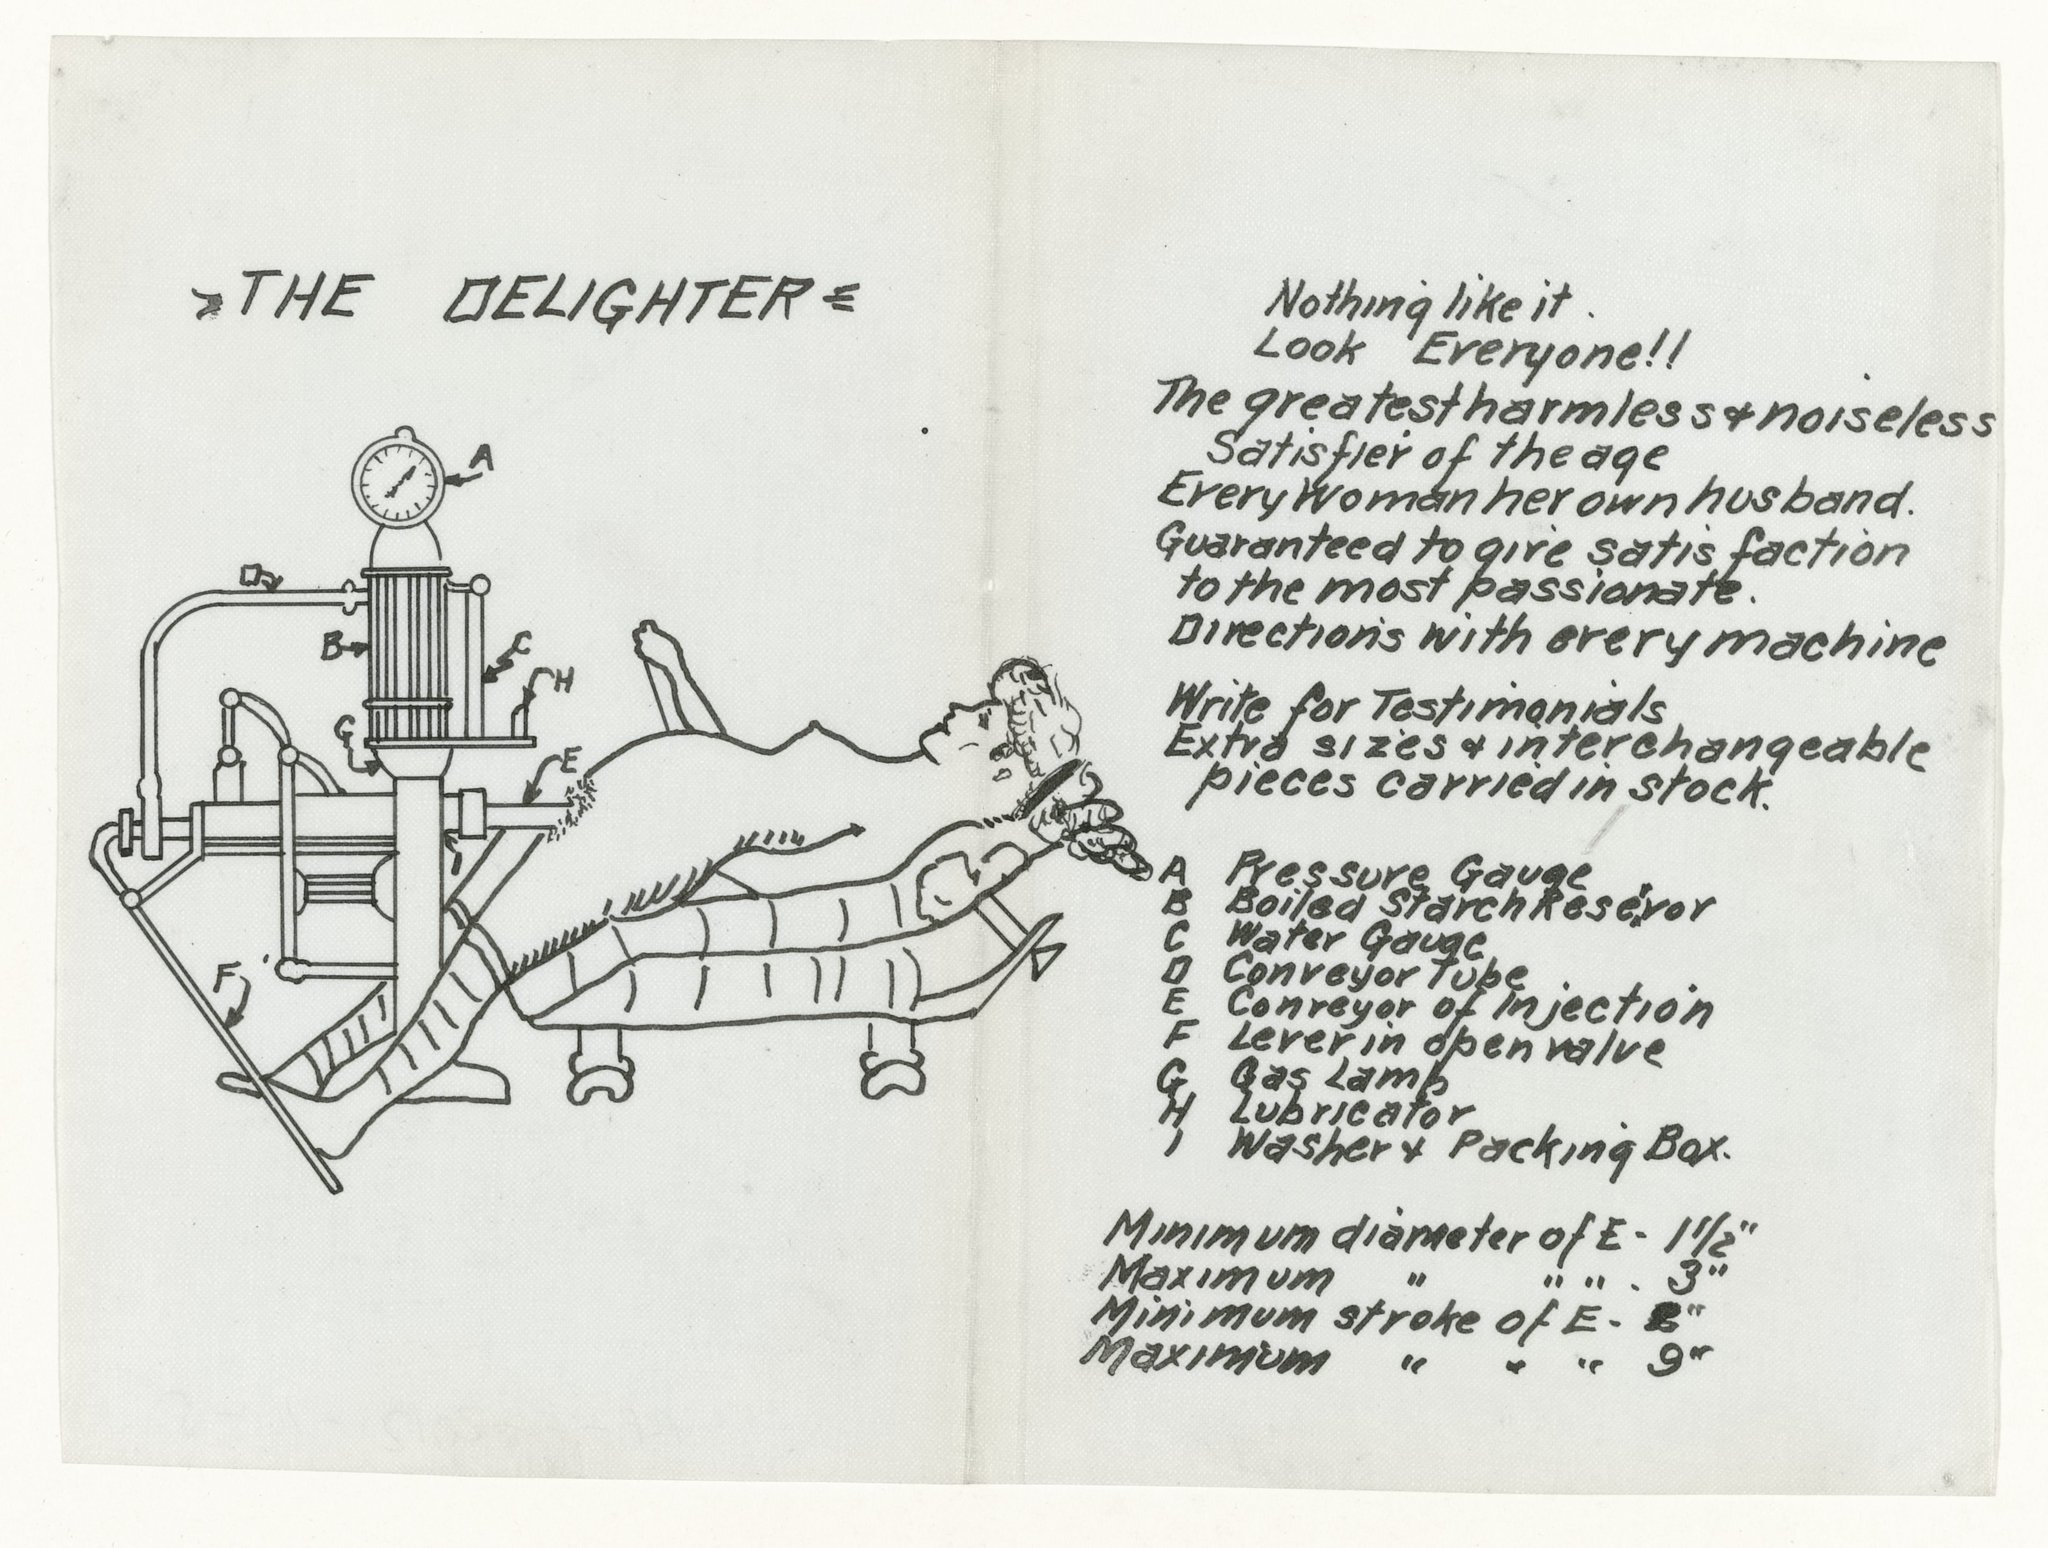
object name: drawing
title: Risqué onderwerp, ontwerp voor de 'Delighter'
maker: Anonymous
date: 1900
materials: ink, textile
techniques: pen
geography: united states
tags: scabrous scenes, pornography, masturbation, onanism (+ variant)